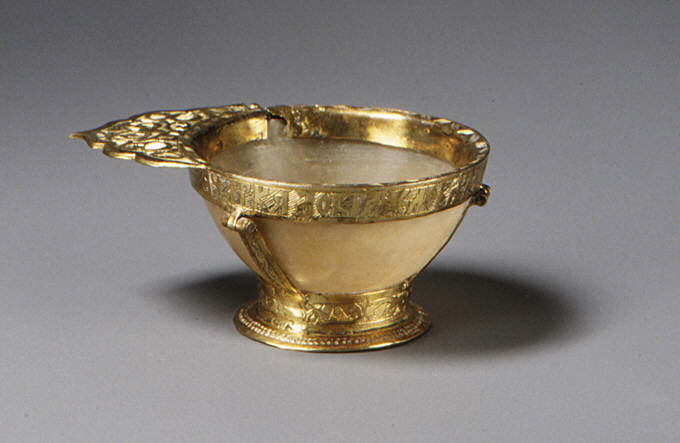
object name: charka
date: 1601-1700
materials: stone, silver gilt